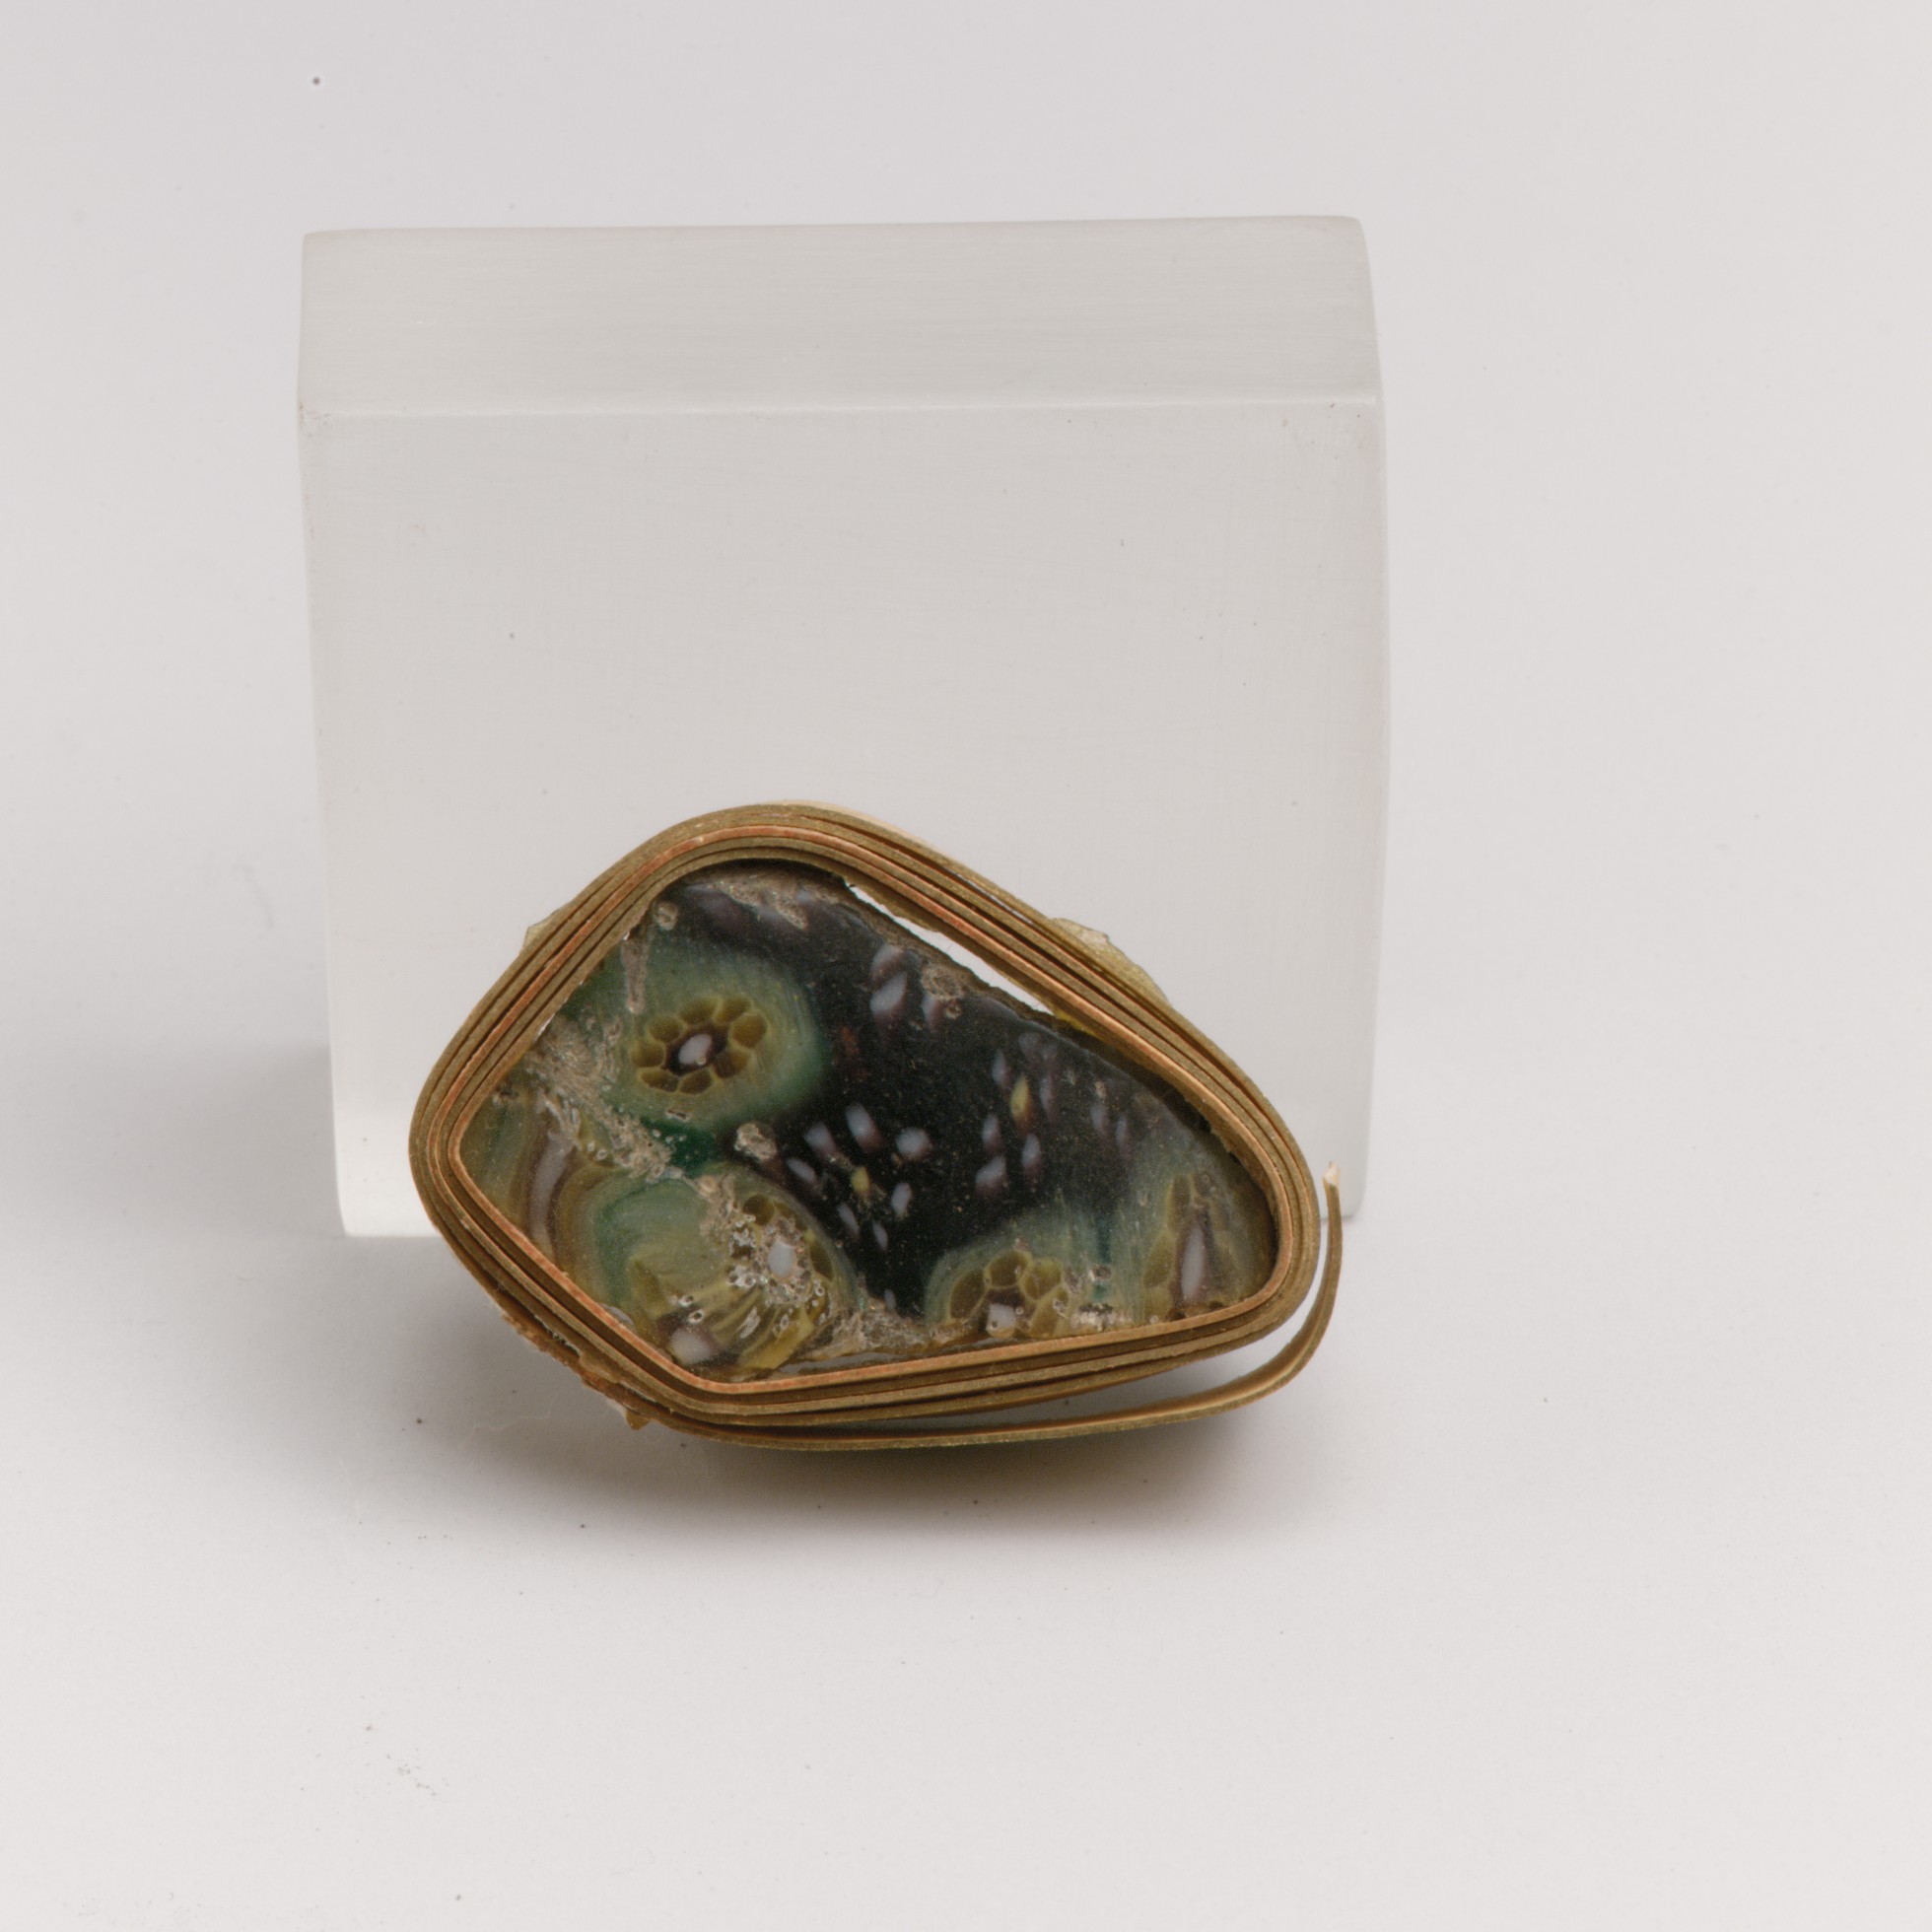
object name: fragment, mosaic bowl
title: Glass mosaic bowl fragment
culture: roman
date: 34 BCE-33 CE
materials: glass